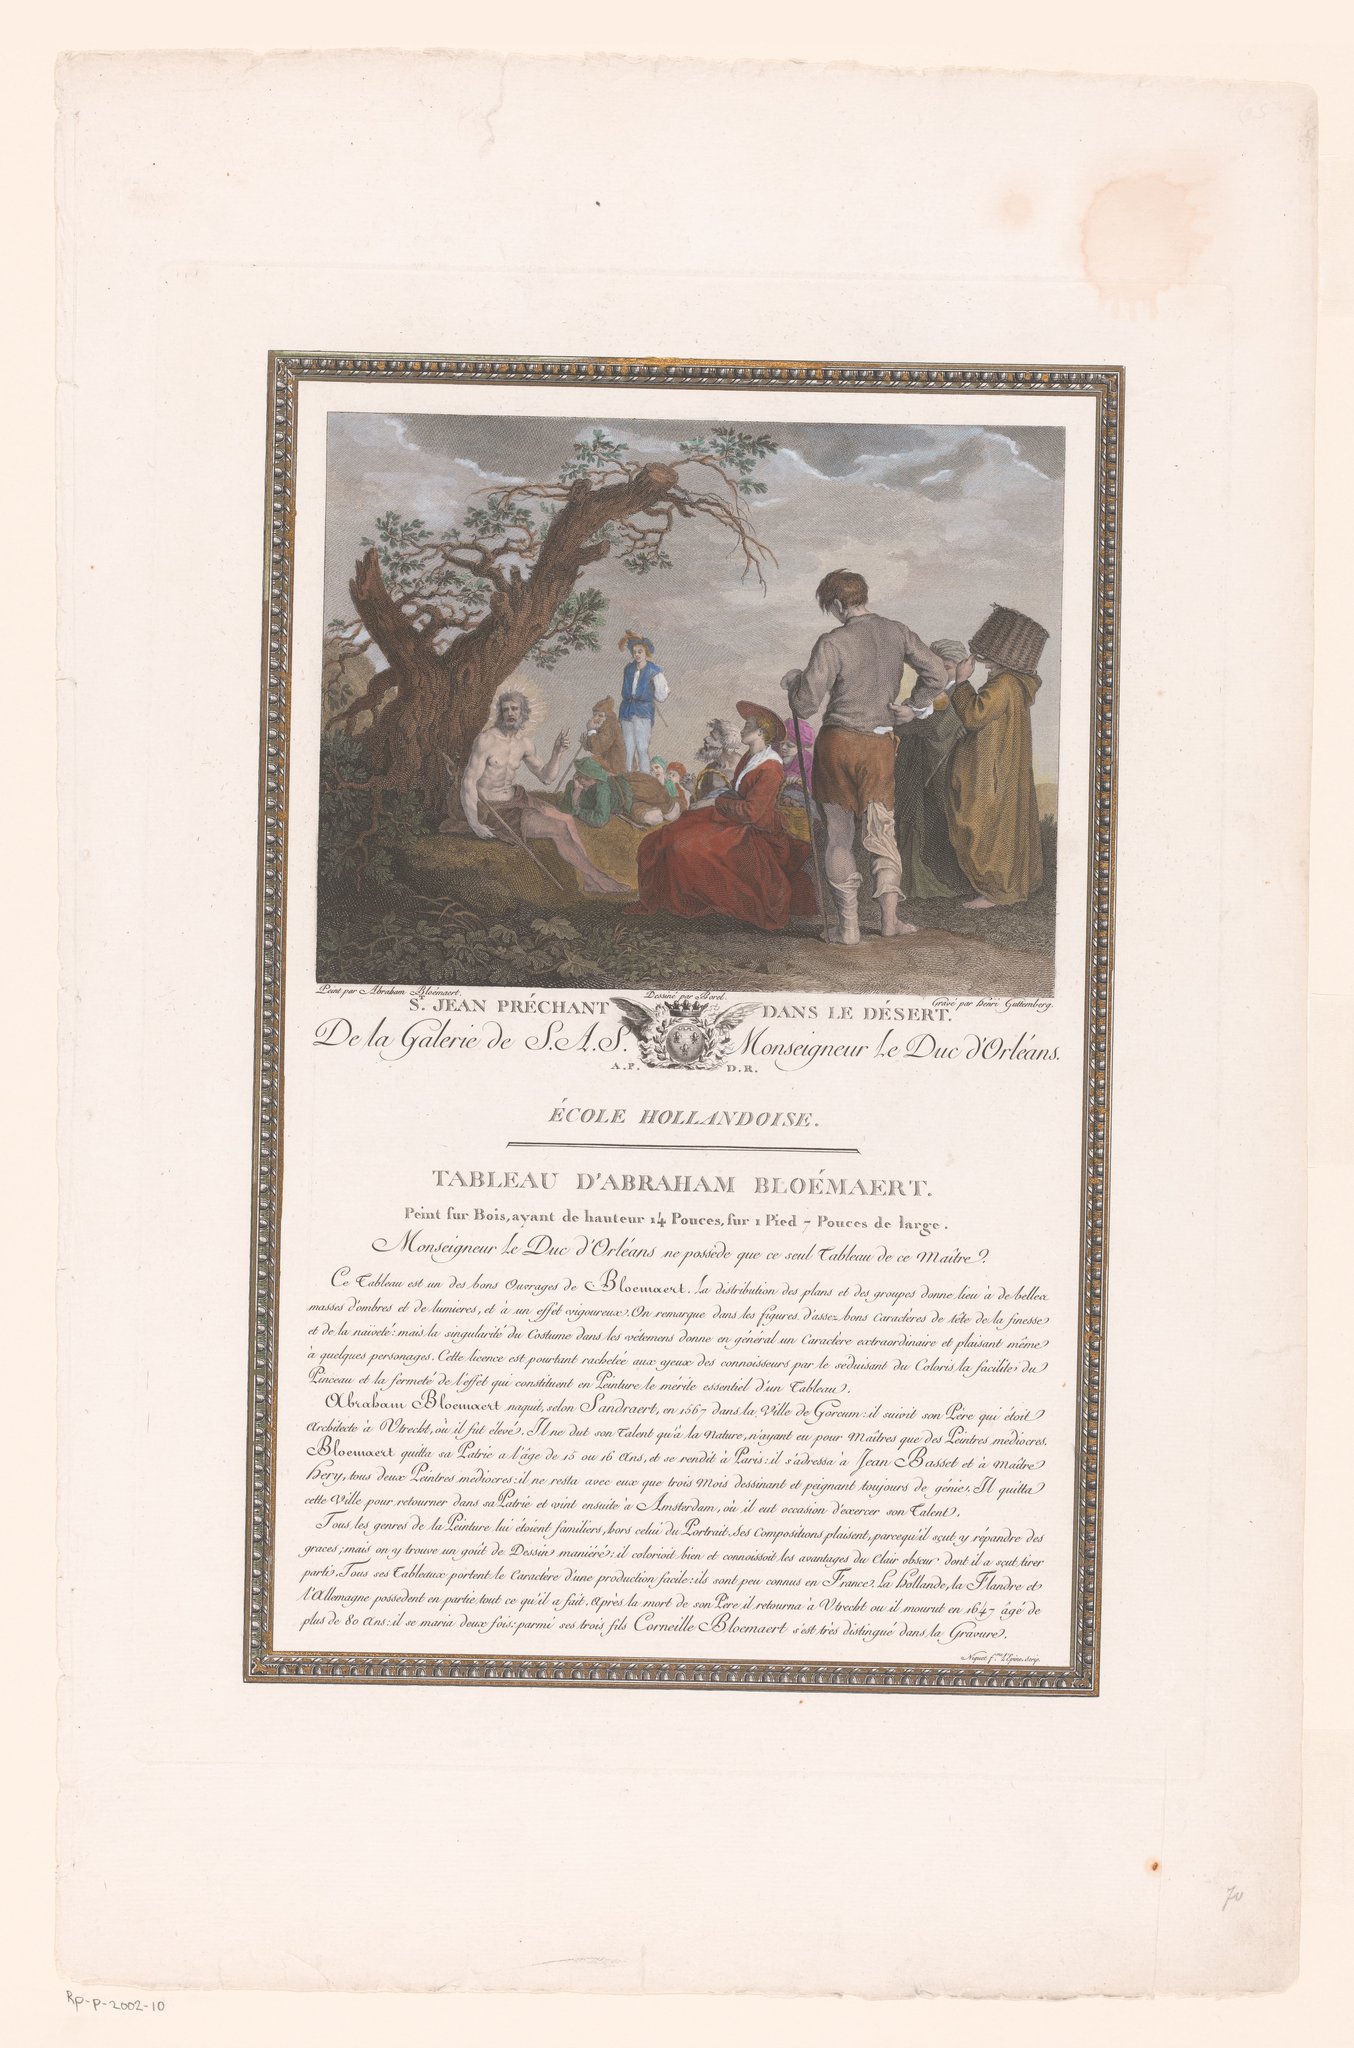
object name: print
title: St. Jean préchant dans le désert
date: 1786-1808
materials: paper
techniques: engraving, etching, hand coloring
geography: paris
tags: john the baptist preaching (perhaps christ among the bystanders)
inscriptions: collector's mark: Lugt 2228